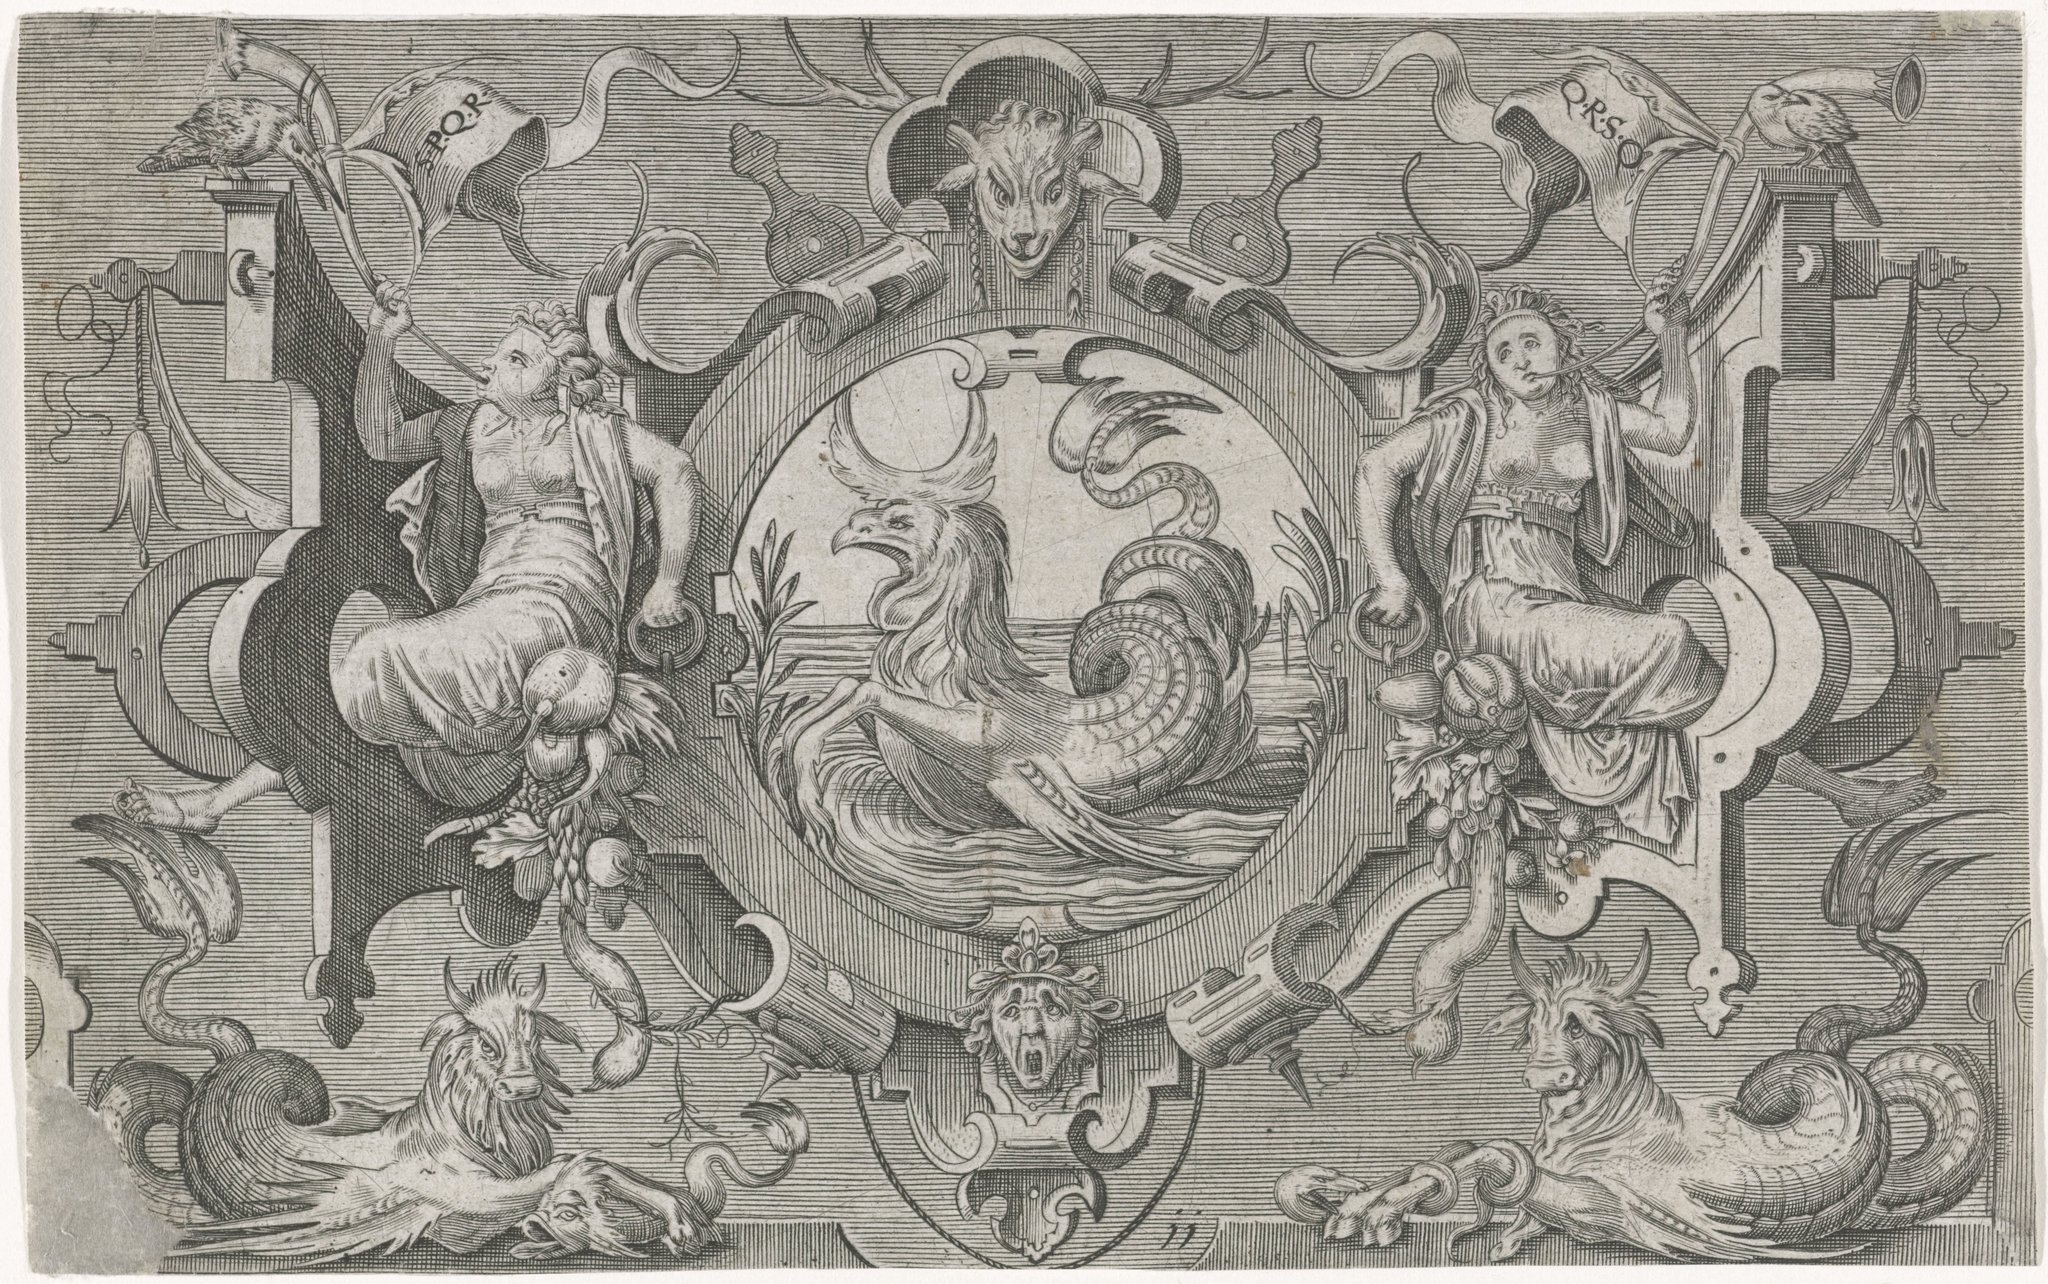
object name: print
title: Cartouche met een zeewezen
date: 1564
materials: paper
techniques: engraving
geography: antwerp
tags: fabulous animals (sometimes wrongly called 'grotesques'); 'mostri' (ripa), scrollwork, strapwork ~ ornament, ornament ~ cartouche, mask, mascaron ~ ornament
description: Cartouche met een zeewezen, voorzien van een hanenkop, een lange gekrulde vissenstaart en voorpoten. De cartouche heeft een omlijsting van krulwerk. Links en rechts een vrouw die op een horen blaast. Aan de horen hangt een vlag. Onder de cartouche twee fantasiewezens. Dit wezen heeft het hoofd en de poten van een rund en de staart van een vis. Onder de voorpoten klemmen zij een vis en een slang. Gearceerde achtergrond. Onderdeel van serie met titelblad en 12 bladen.